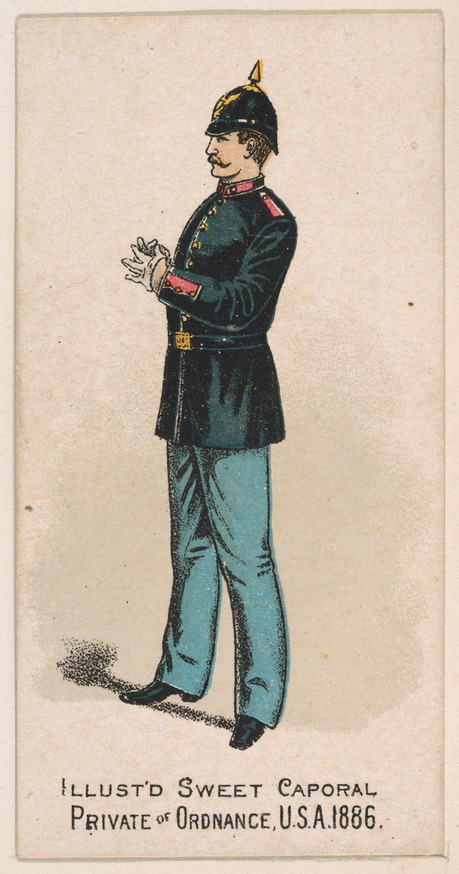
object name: print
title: Private of Ordnance, United States Army, 1886, from the Military Series (N224) issued by Kinney Tobacco Company to promote Sweet Caporal Cigarettes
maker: kinney brothers tobacco company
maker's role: publisher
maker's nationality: american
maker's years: 1869-2011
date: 1888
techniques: color lithograph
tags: army,men,profiles